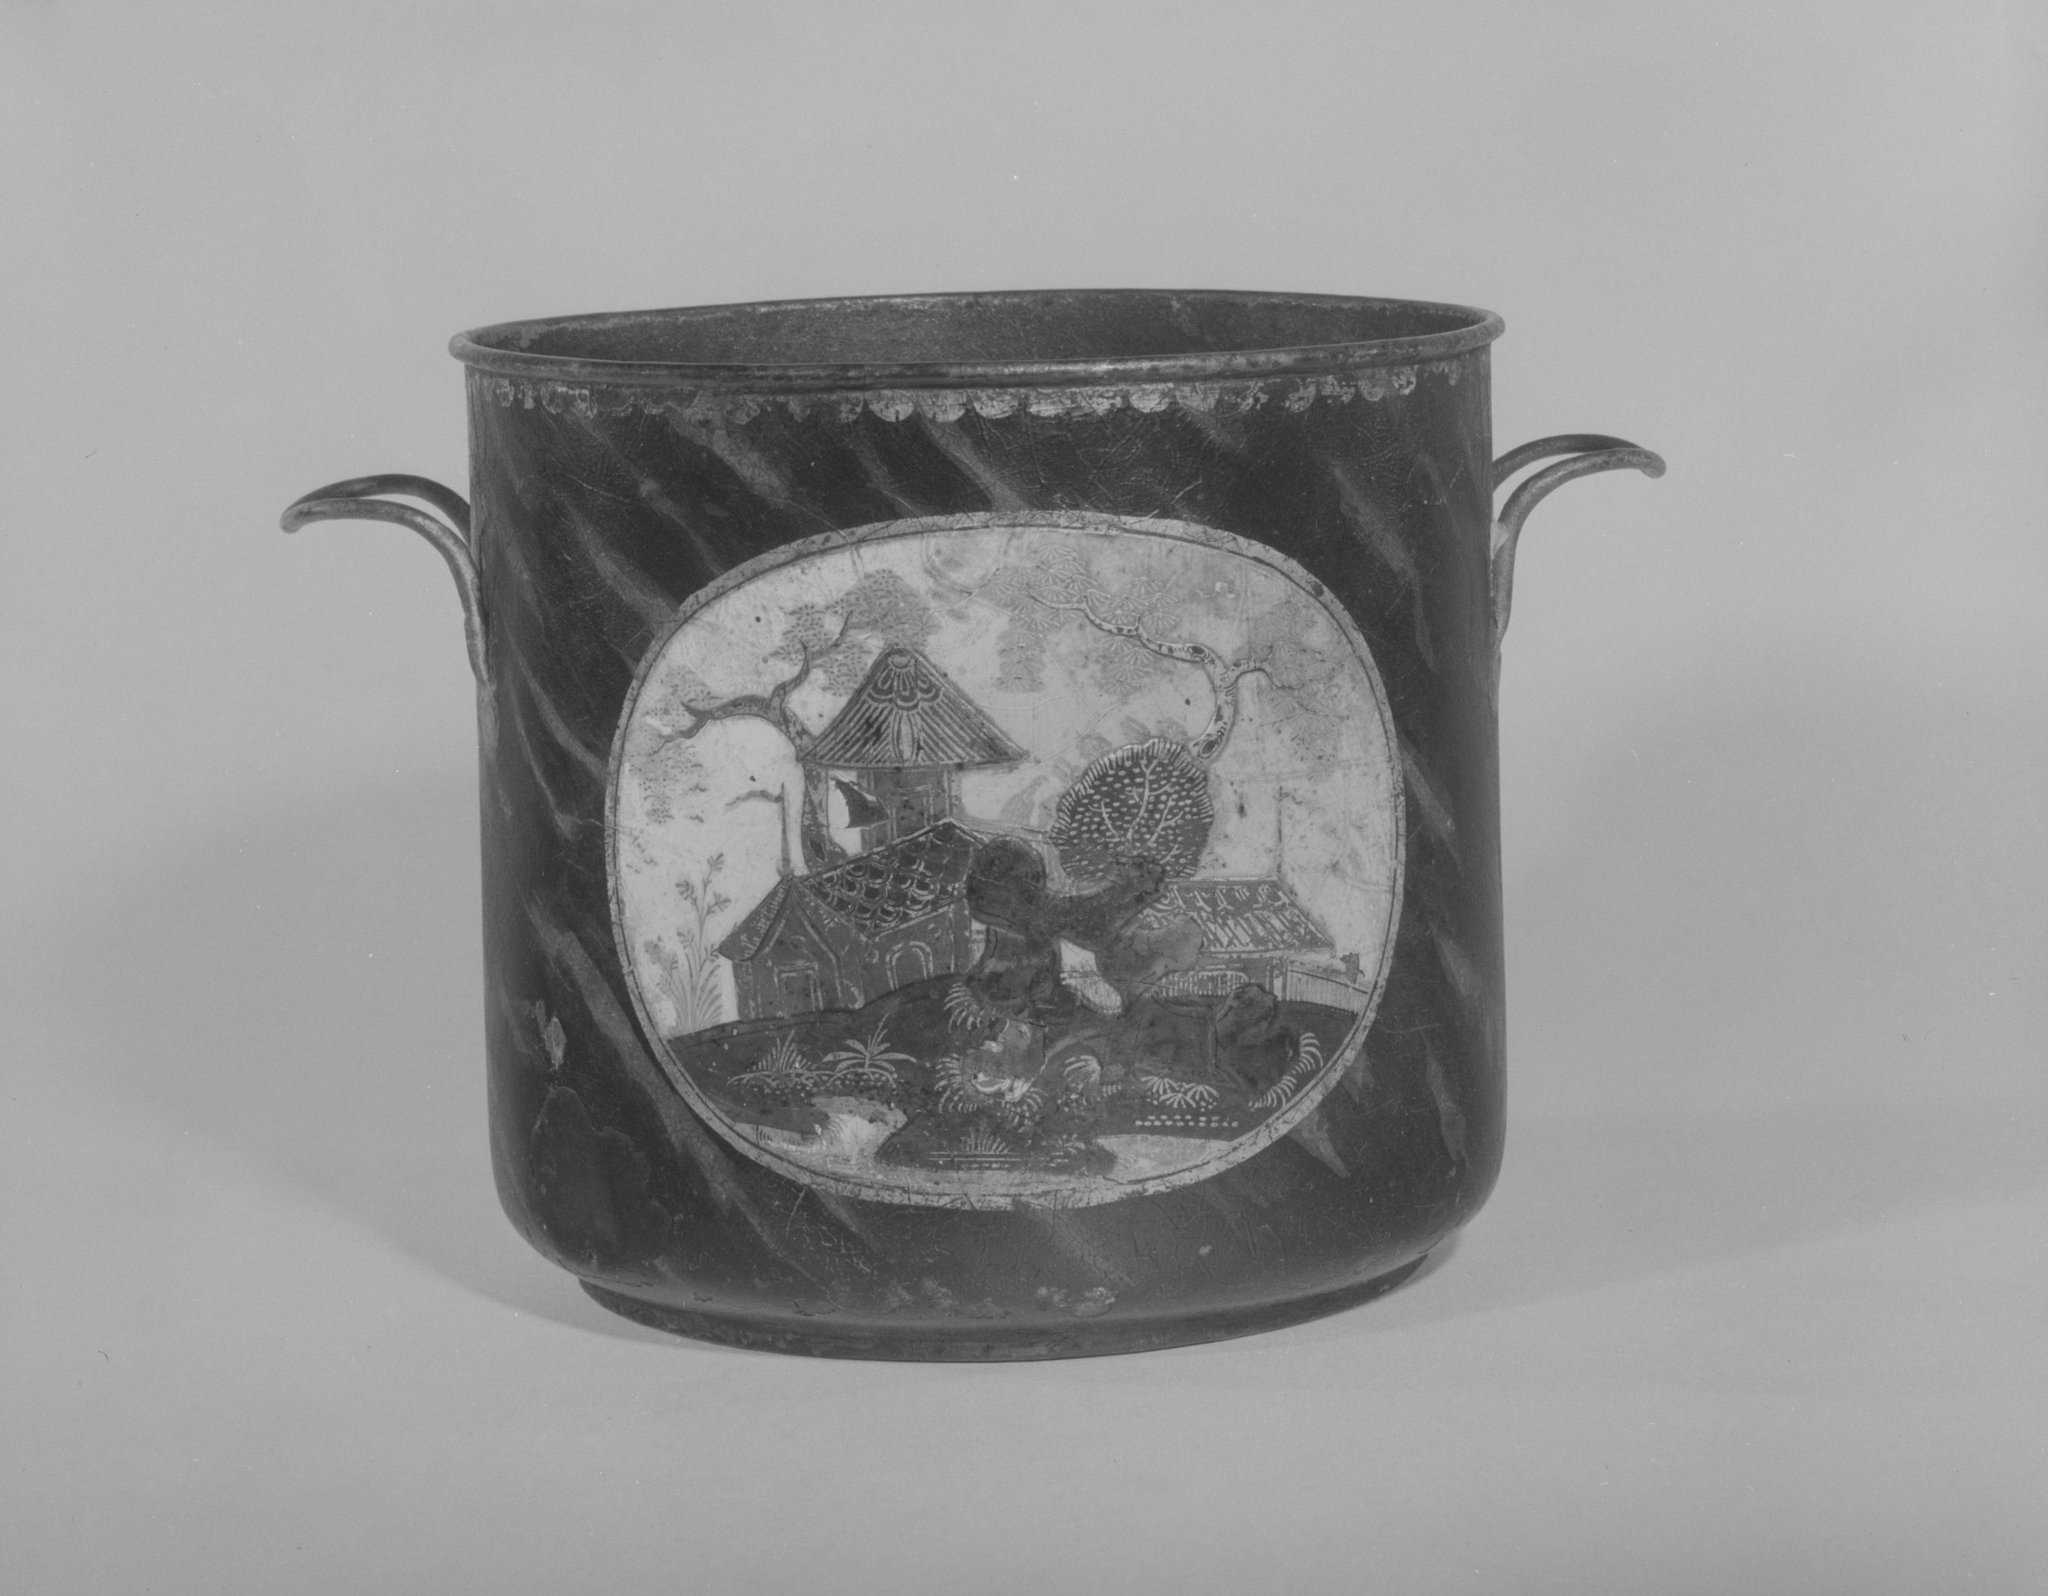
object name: cachepot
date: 1700-1800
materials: tin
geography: france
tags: trees